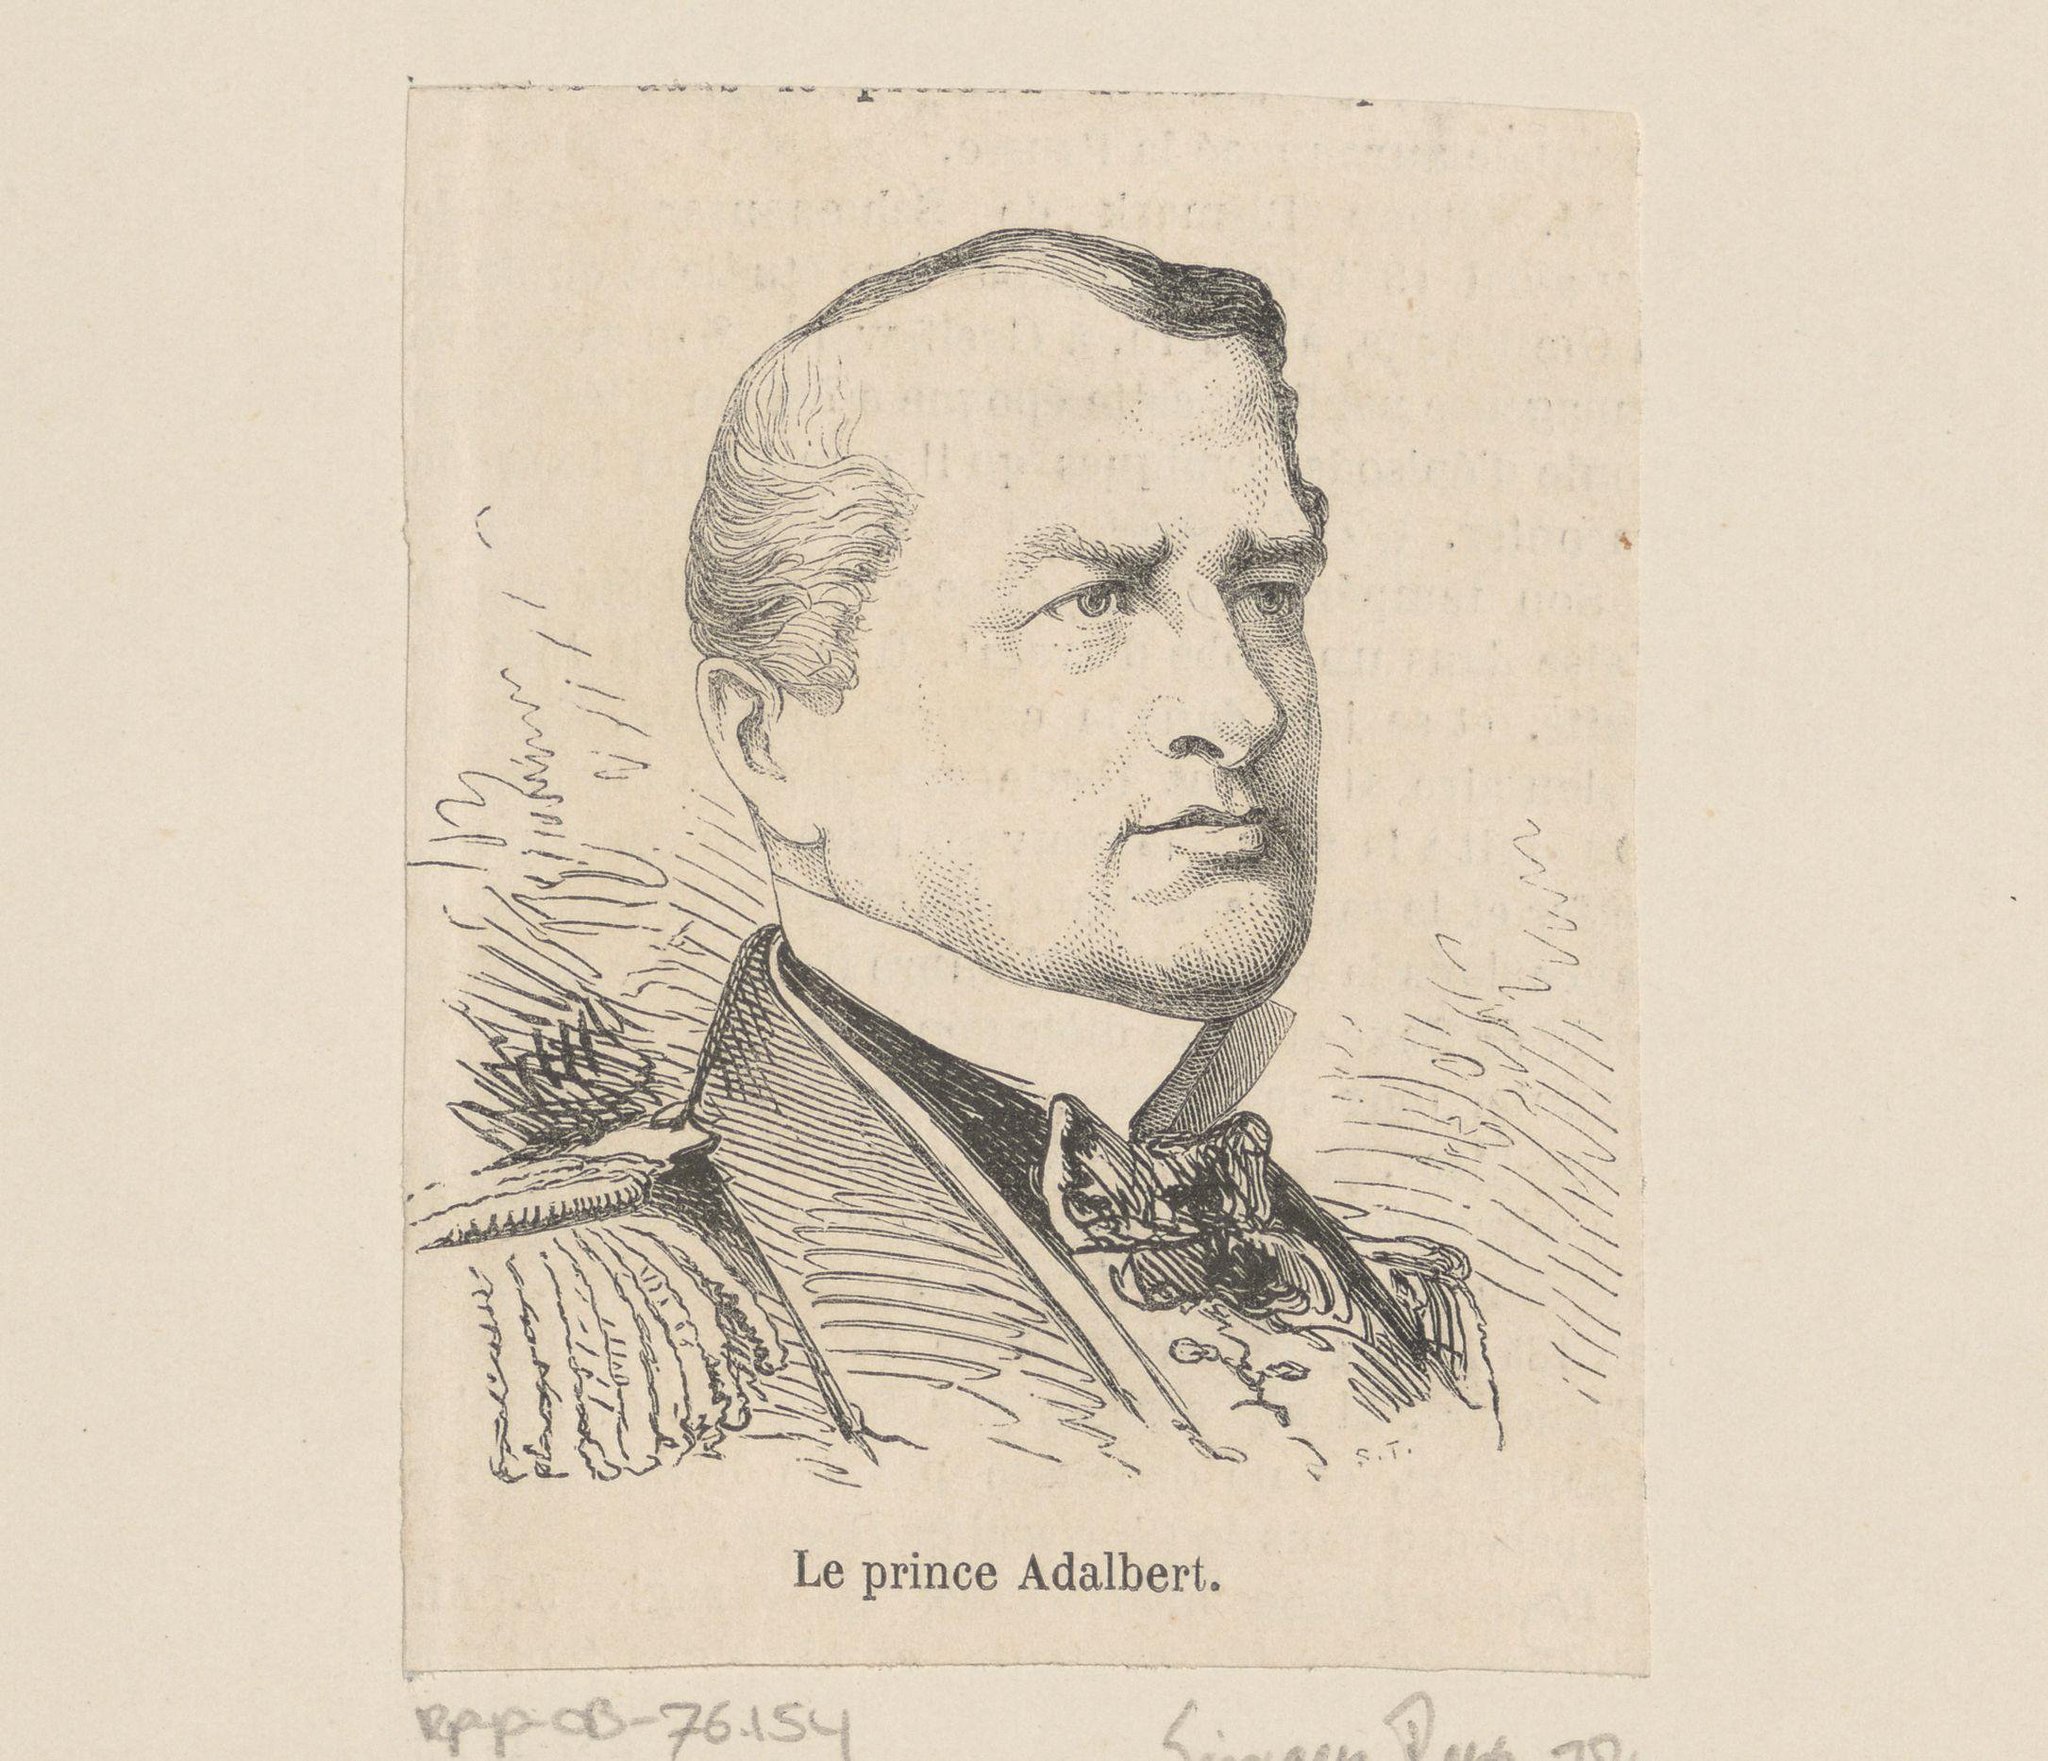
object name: print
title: Portret van Adalbert, prins van Pruisen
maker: monogrammist st (19e eeuw)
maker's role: draughtsman, print maker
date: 1835-1899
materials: paper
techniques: letterpress printing, engraving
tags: berlin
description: Portret van Adalbert. In de ondermarge zijn naam en titel in boekdruk.